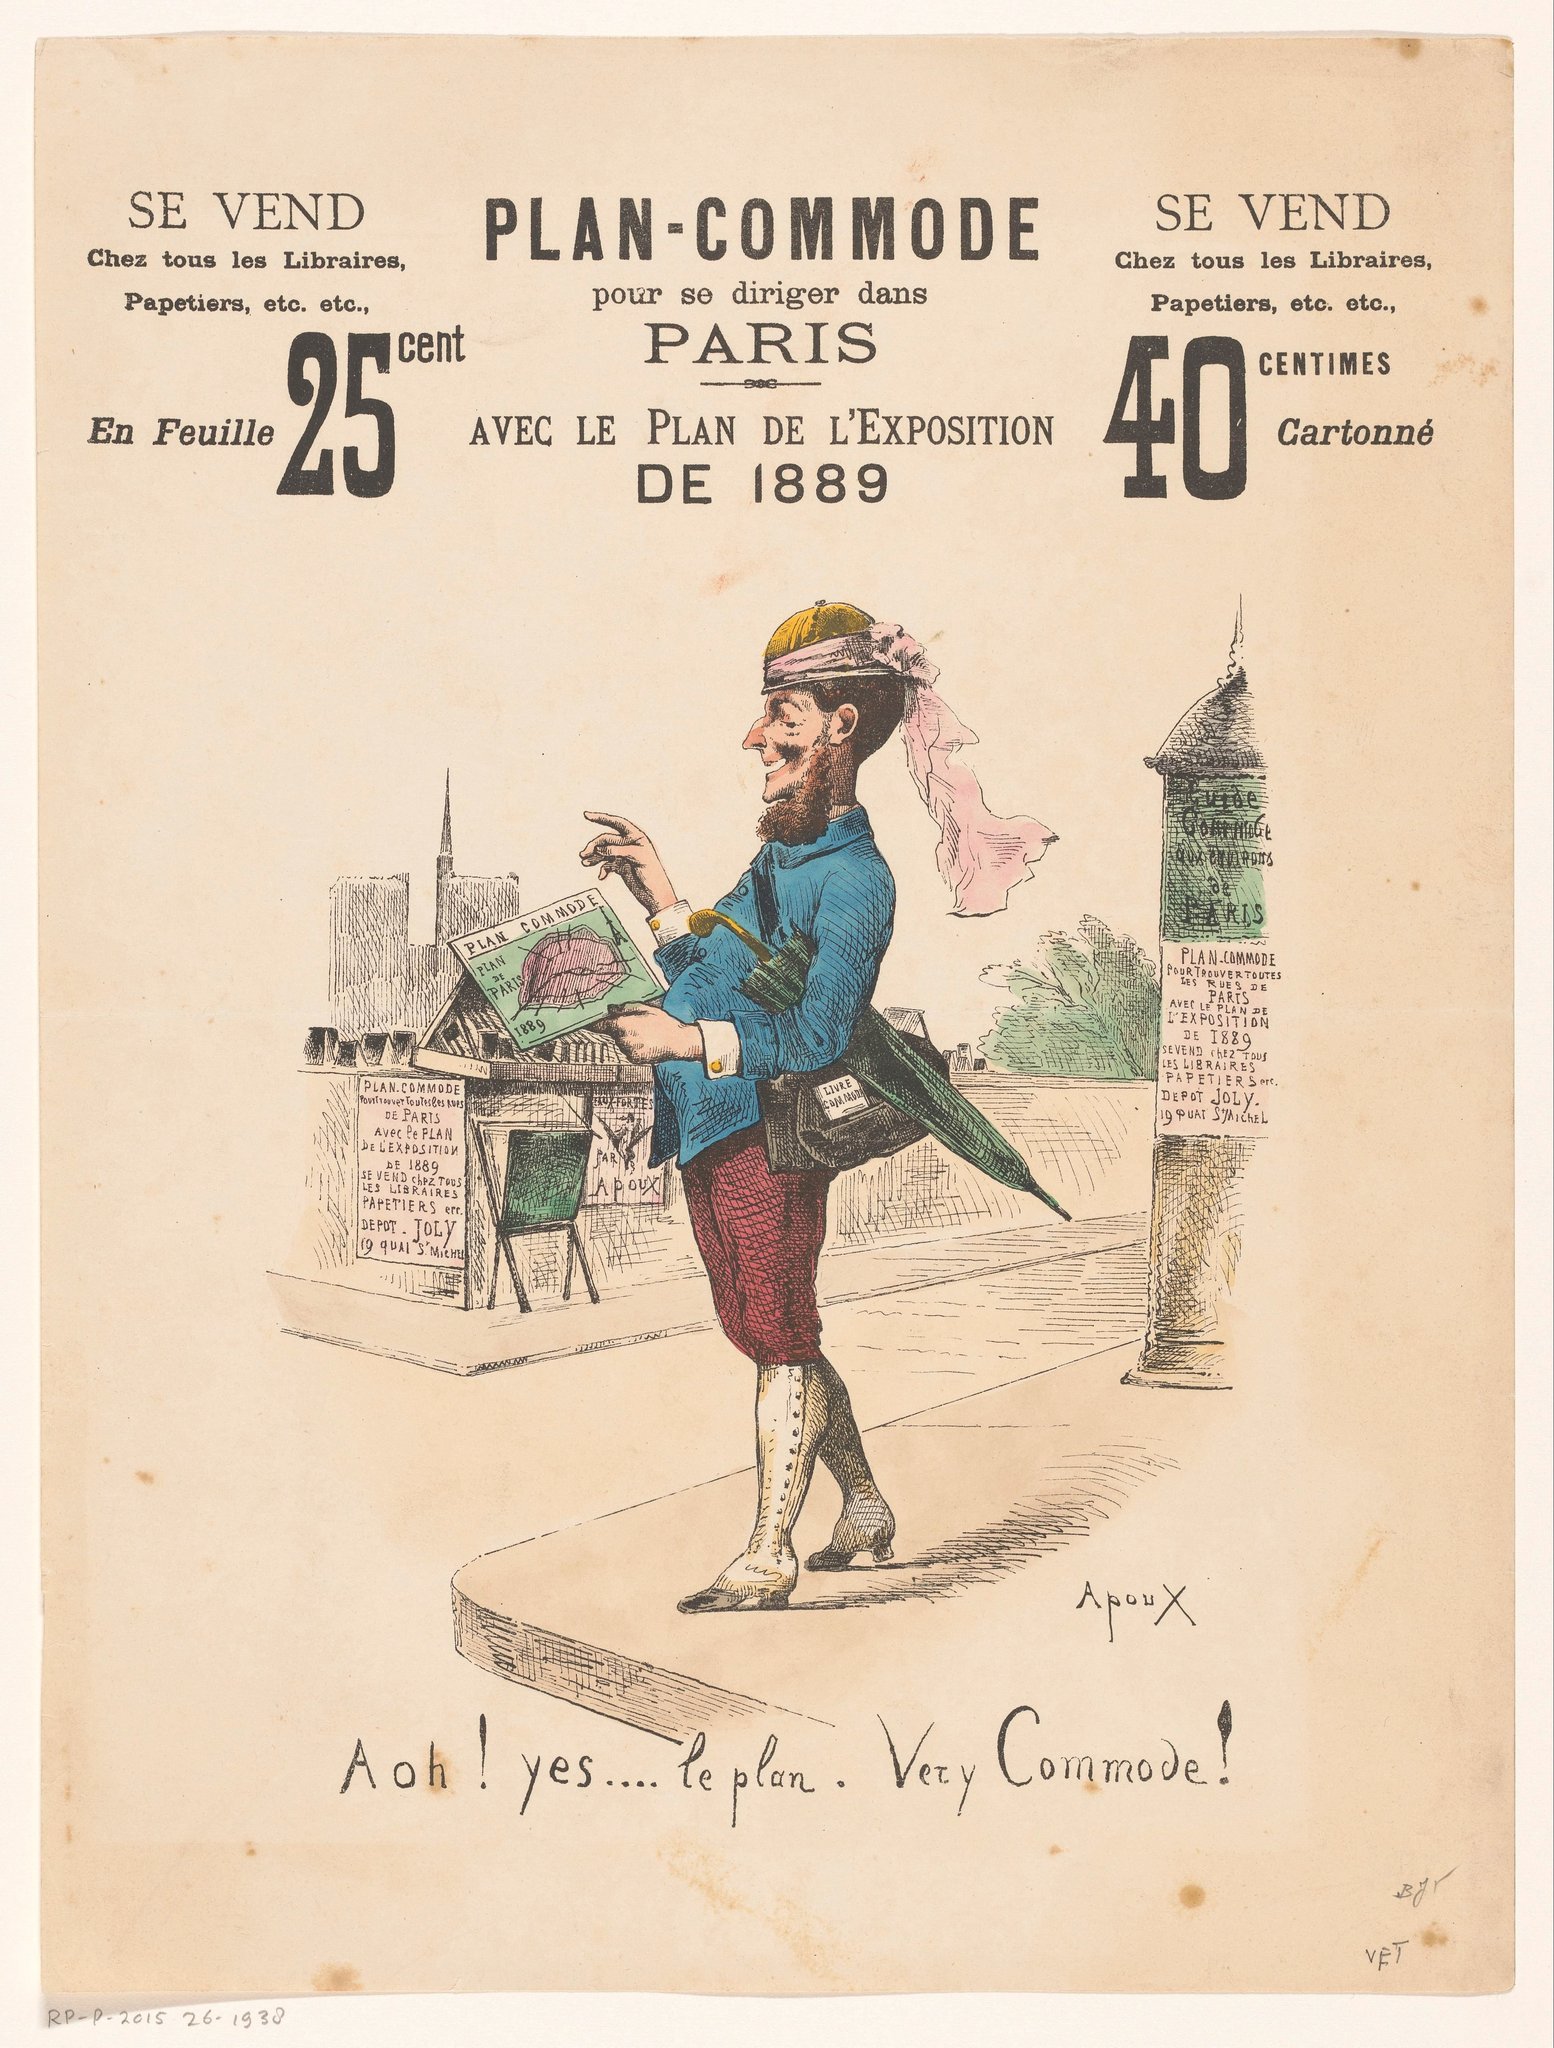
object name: print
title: Aoh! yes (...) le plan. Very Commode!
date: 1889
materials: paper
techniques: hand coloring, lithograph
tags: book-stall, kiosk, caricatures (human types), poster-pillar, maps of cities, paris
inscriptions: collector's mark: Lugt 2228, collector's mark: Lugt 4779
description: Op een kade staat een Engelse toerist met een paraplu onder zijn arm en een hoed op zijn hoofd. In zijn hand houdt hij een plattegrond van Parijs. In de achtergrond een boekenkraam op een kademuur met in de verte de Notre-Dame. Rechts is een deel van een reclamezuil zichtbaar.